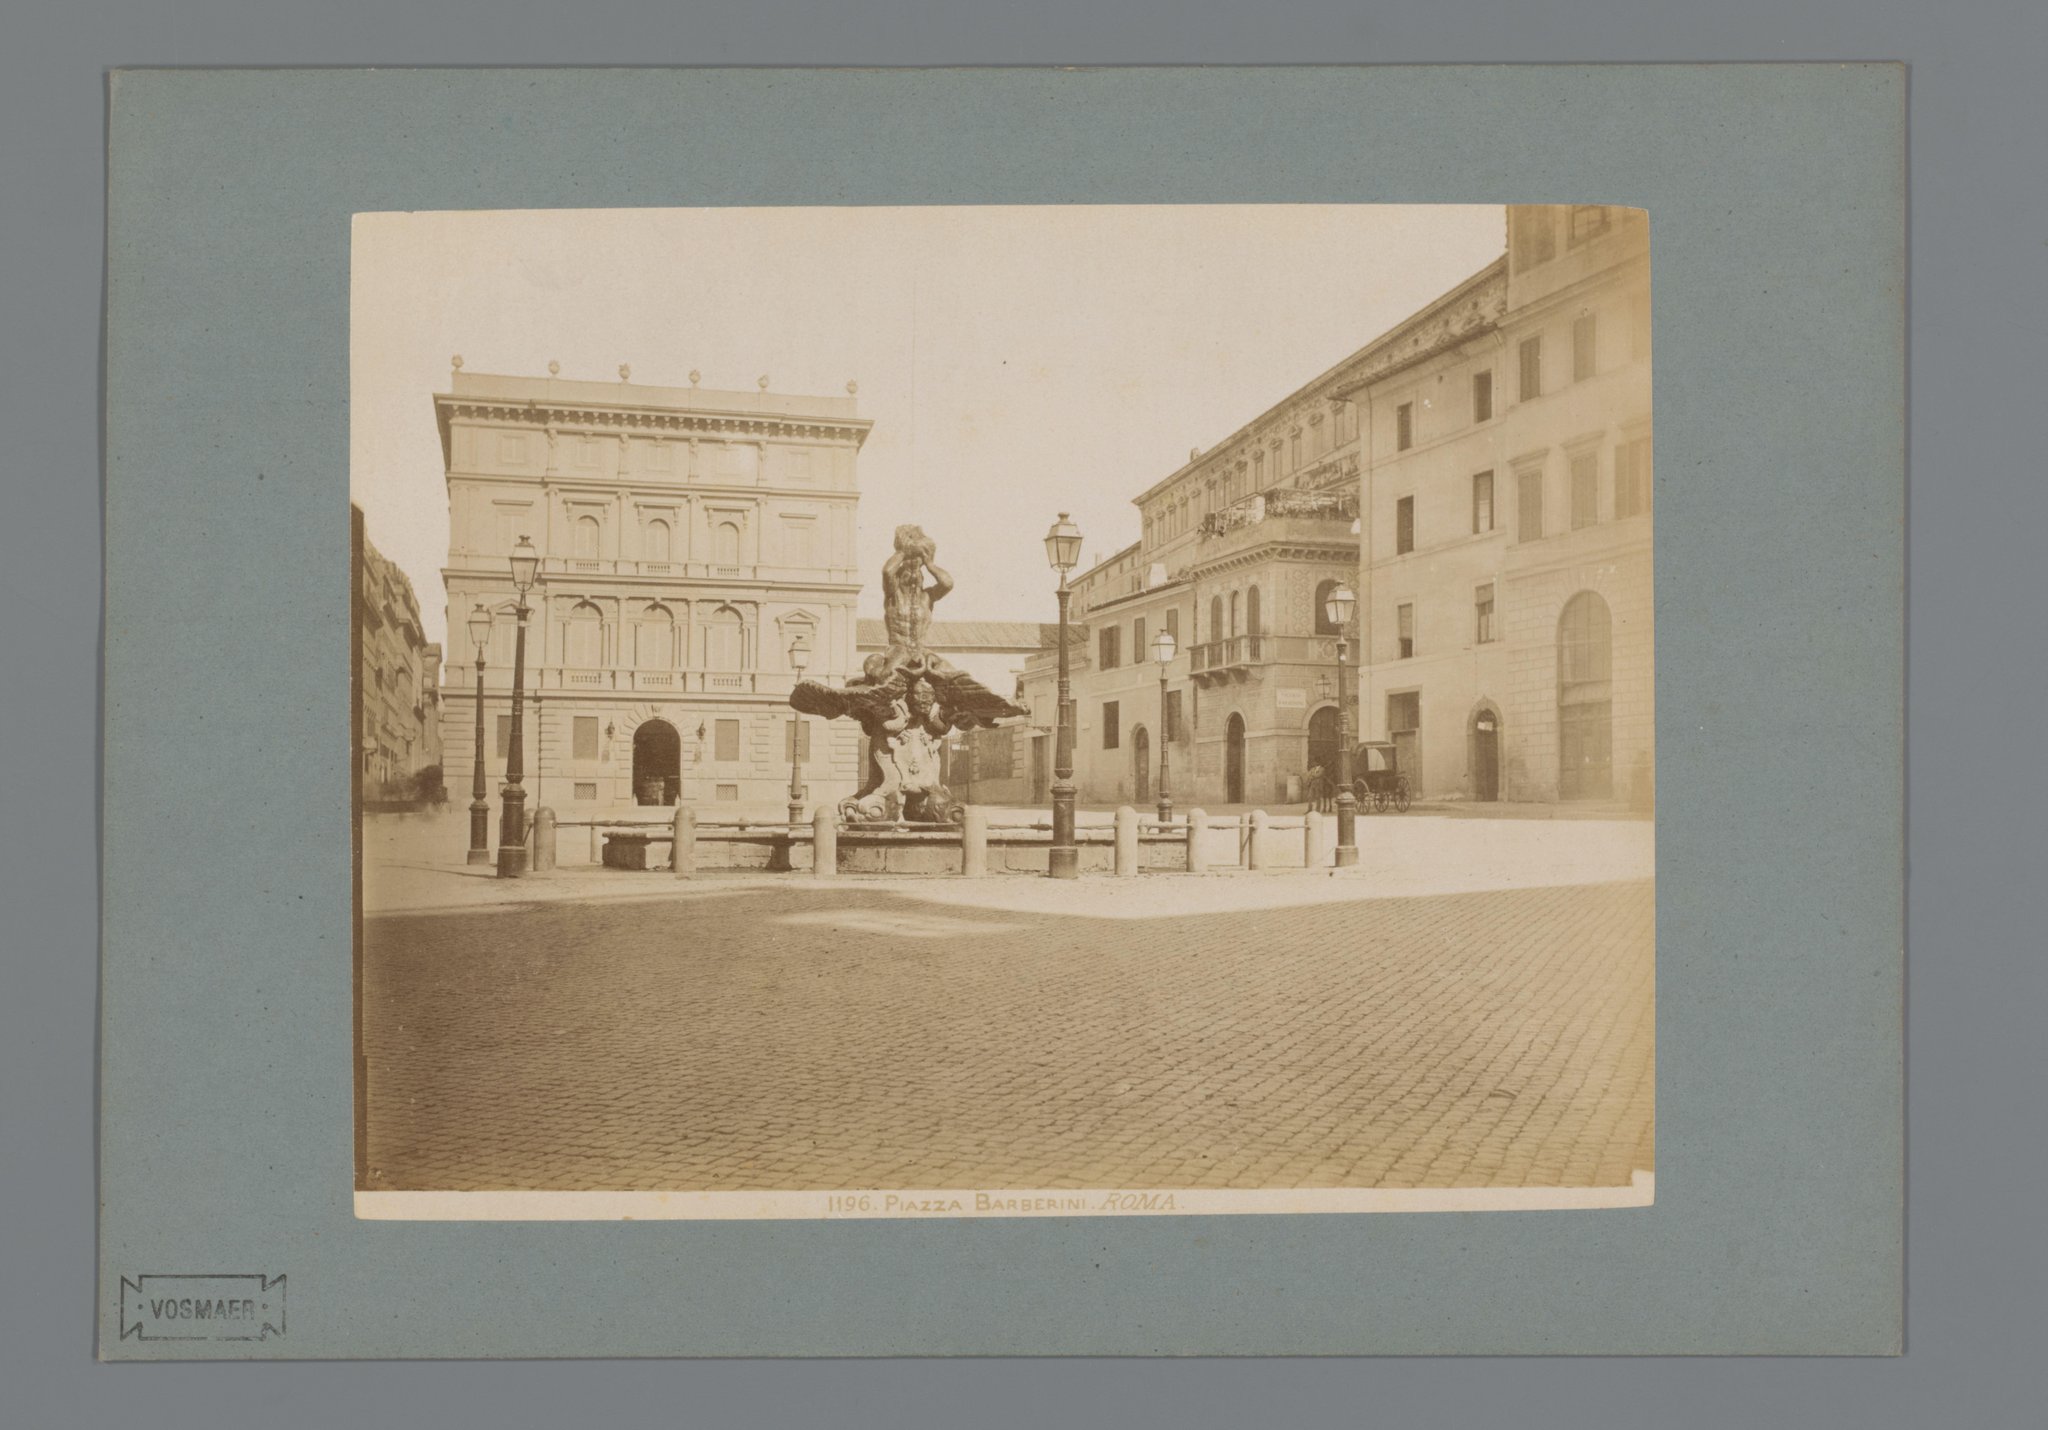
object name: photograph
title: Roma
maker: Anonymous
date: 1851-1890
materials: cardboard, paper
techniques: albumen print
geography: rome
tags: square, place, circus, etc., ornamental fountain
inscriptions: number: ‘1236’, collector's mark: ‘VOSMAER’